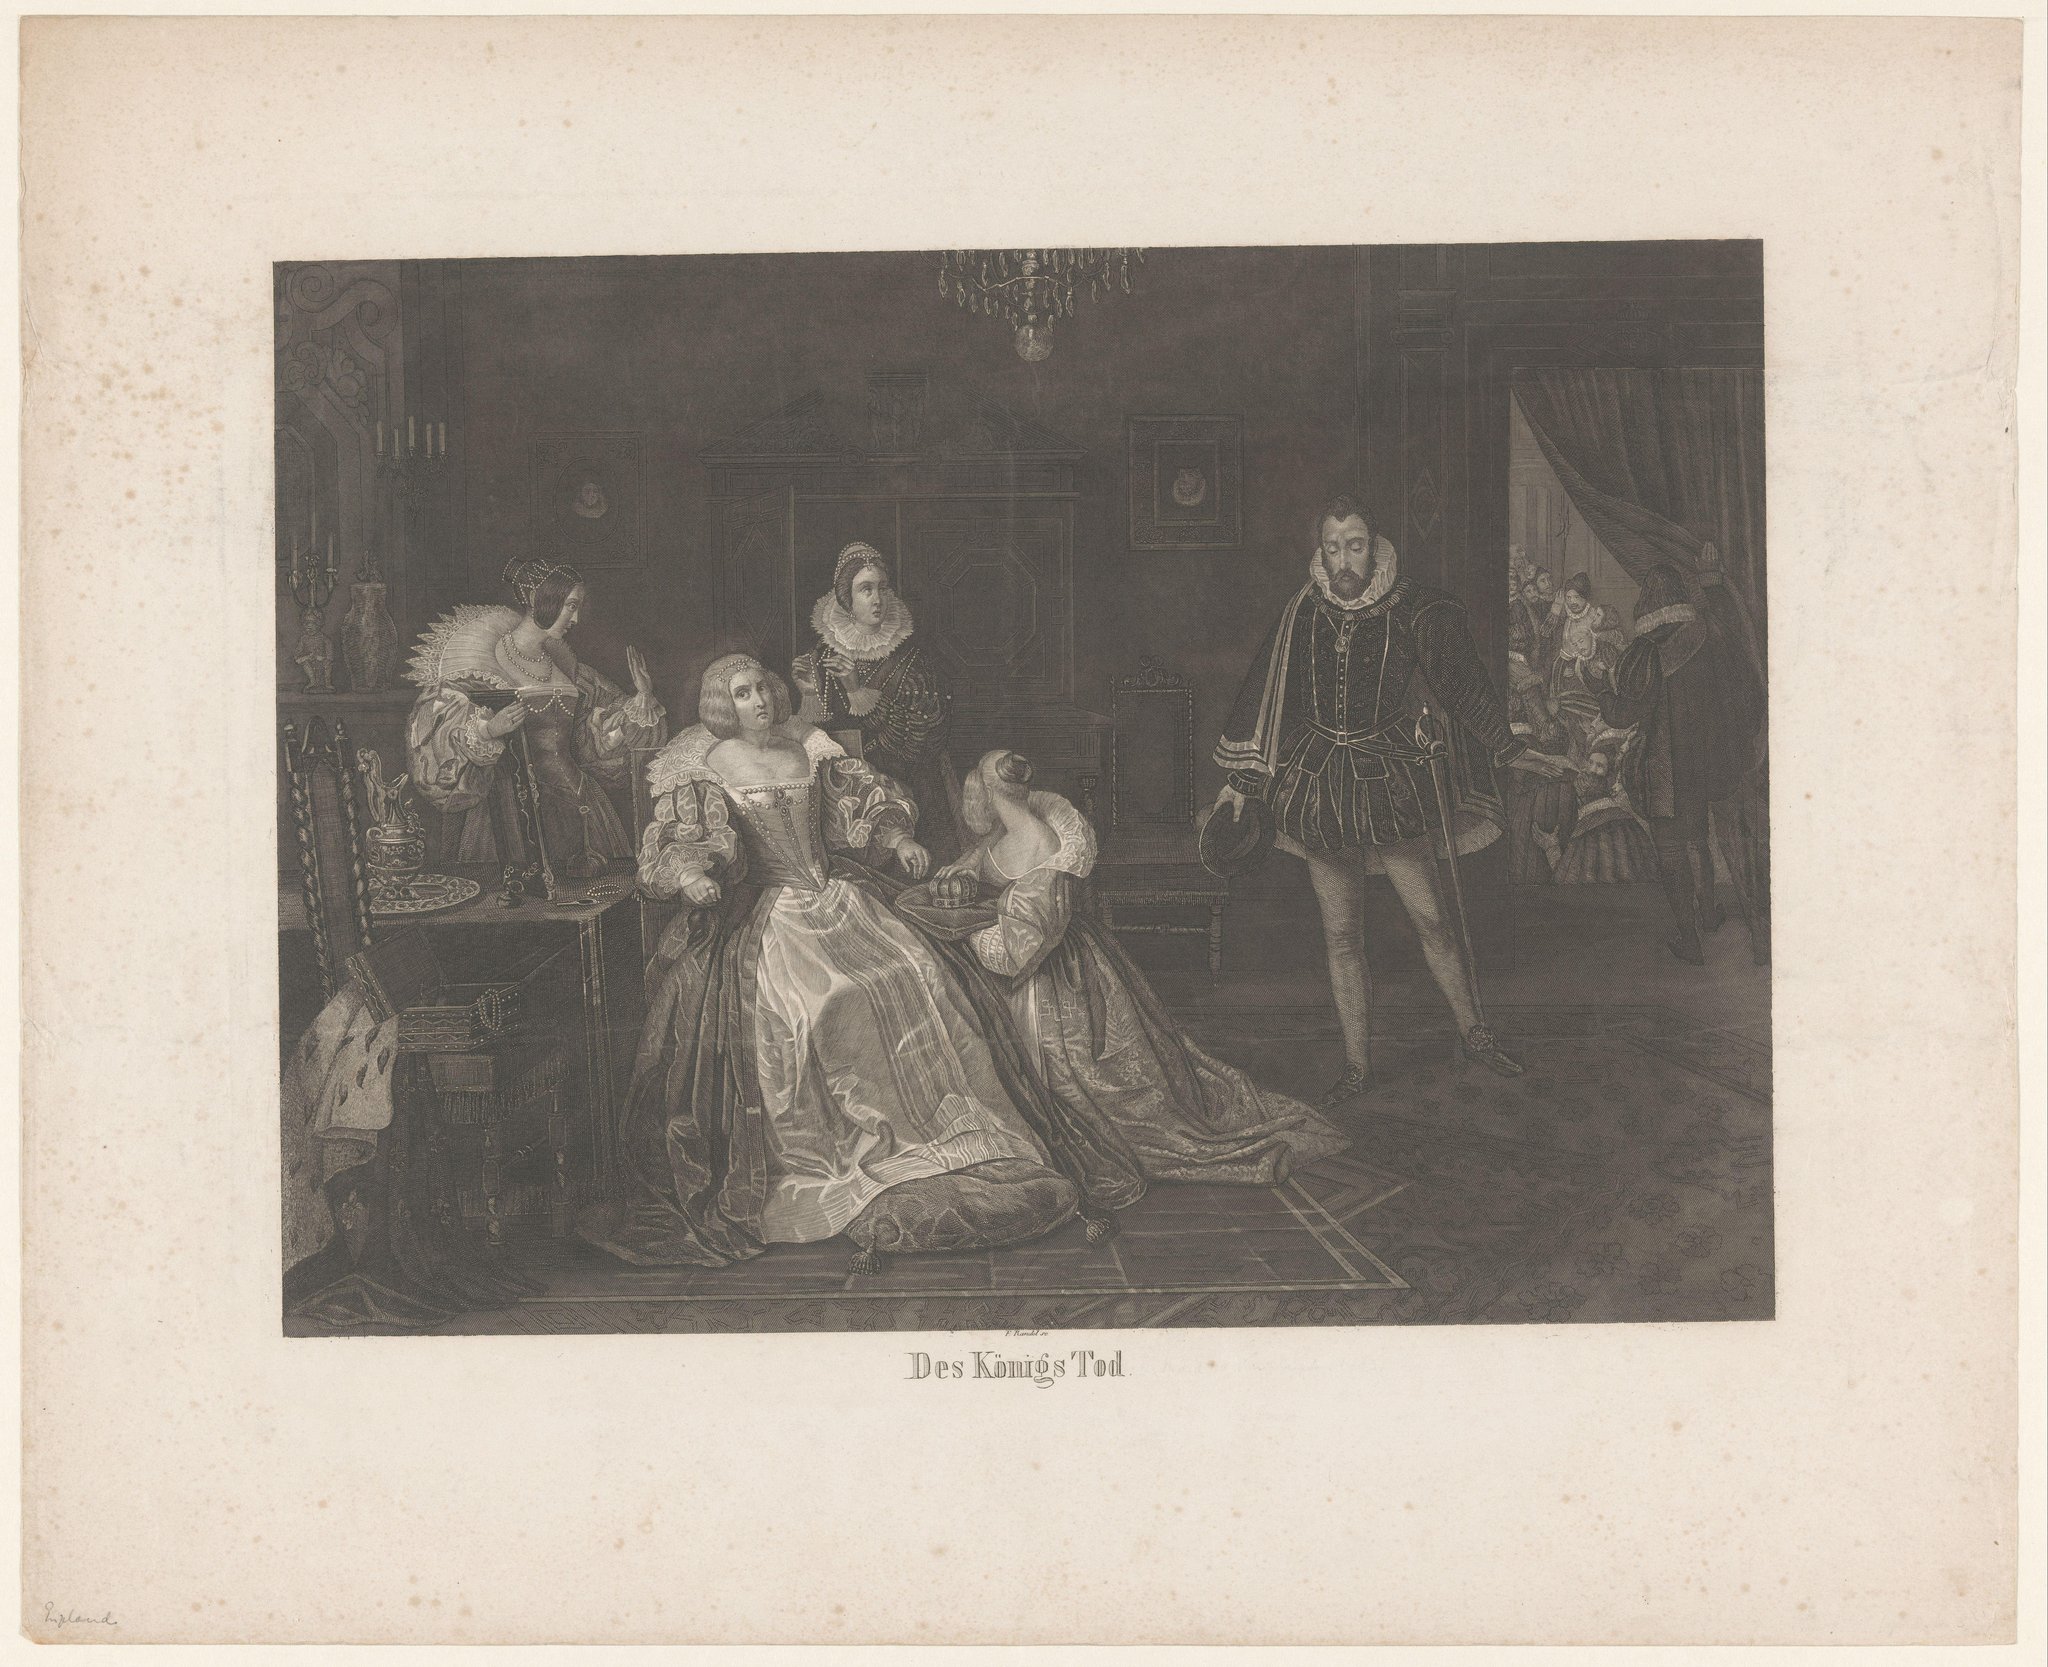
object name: print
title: Des Königs Tod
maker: friedrich randel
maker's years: 1808-1886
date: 1816-1886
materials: paper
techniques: engraving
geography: germany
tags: london, widow, death of human being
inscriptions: collector's mark: Lugt 2228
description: Kennisgeving aan koningin Elizabeth Woodville van de dood van haar man, koning Eduard IV van Engeland, 9 april 1483.